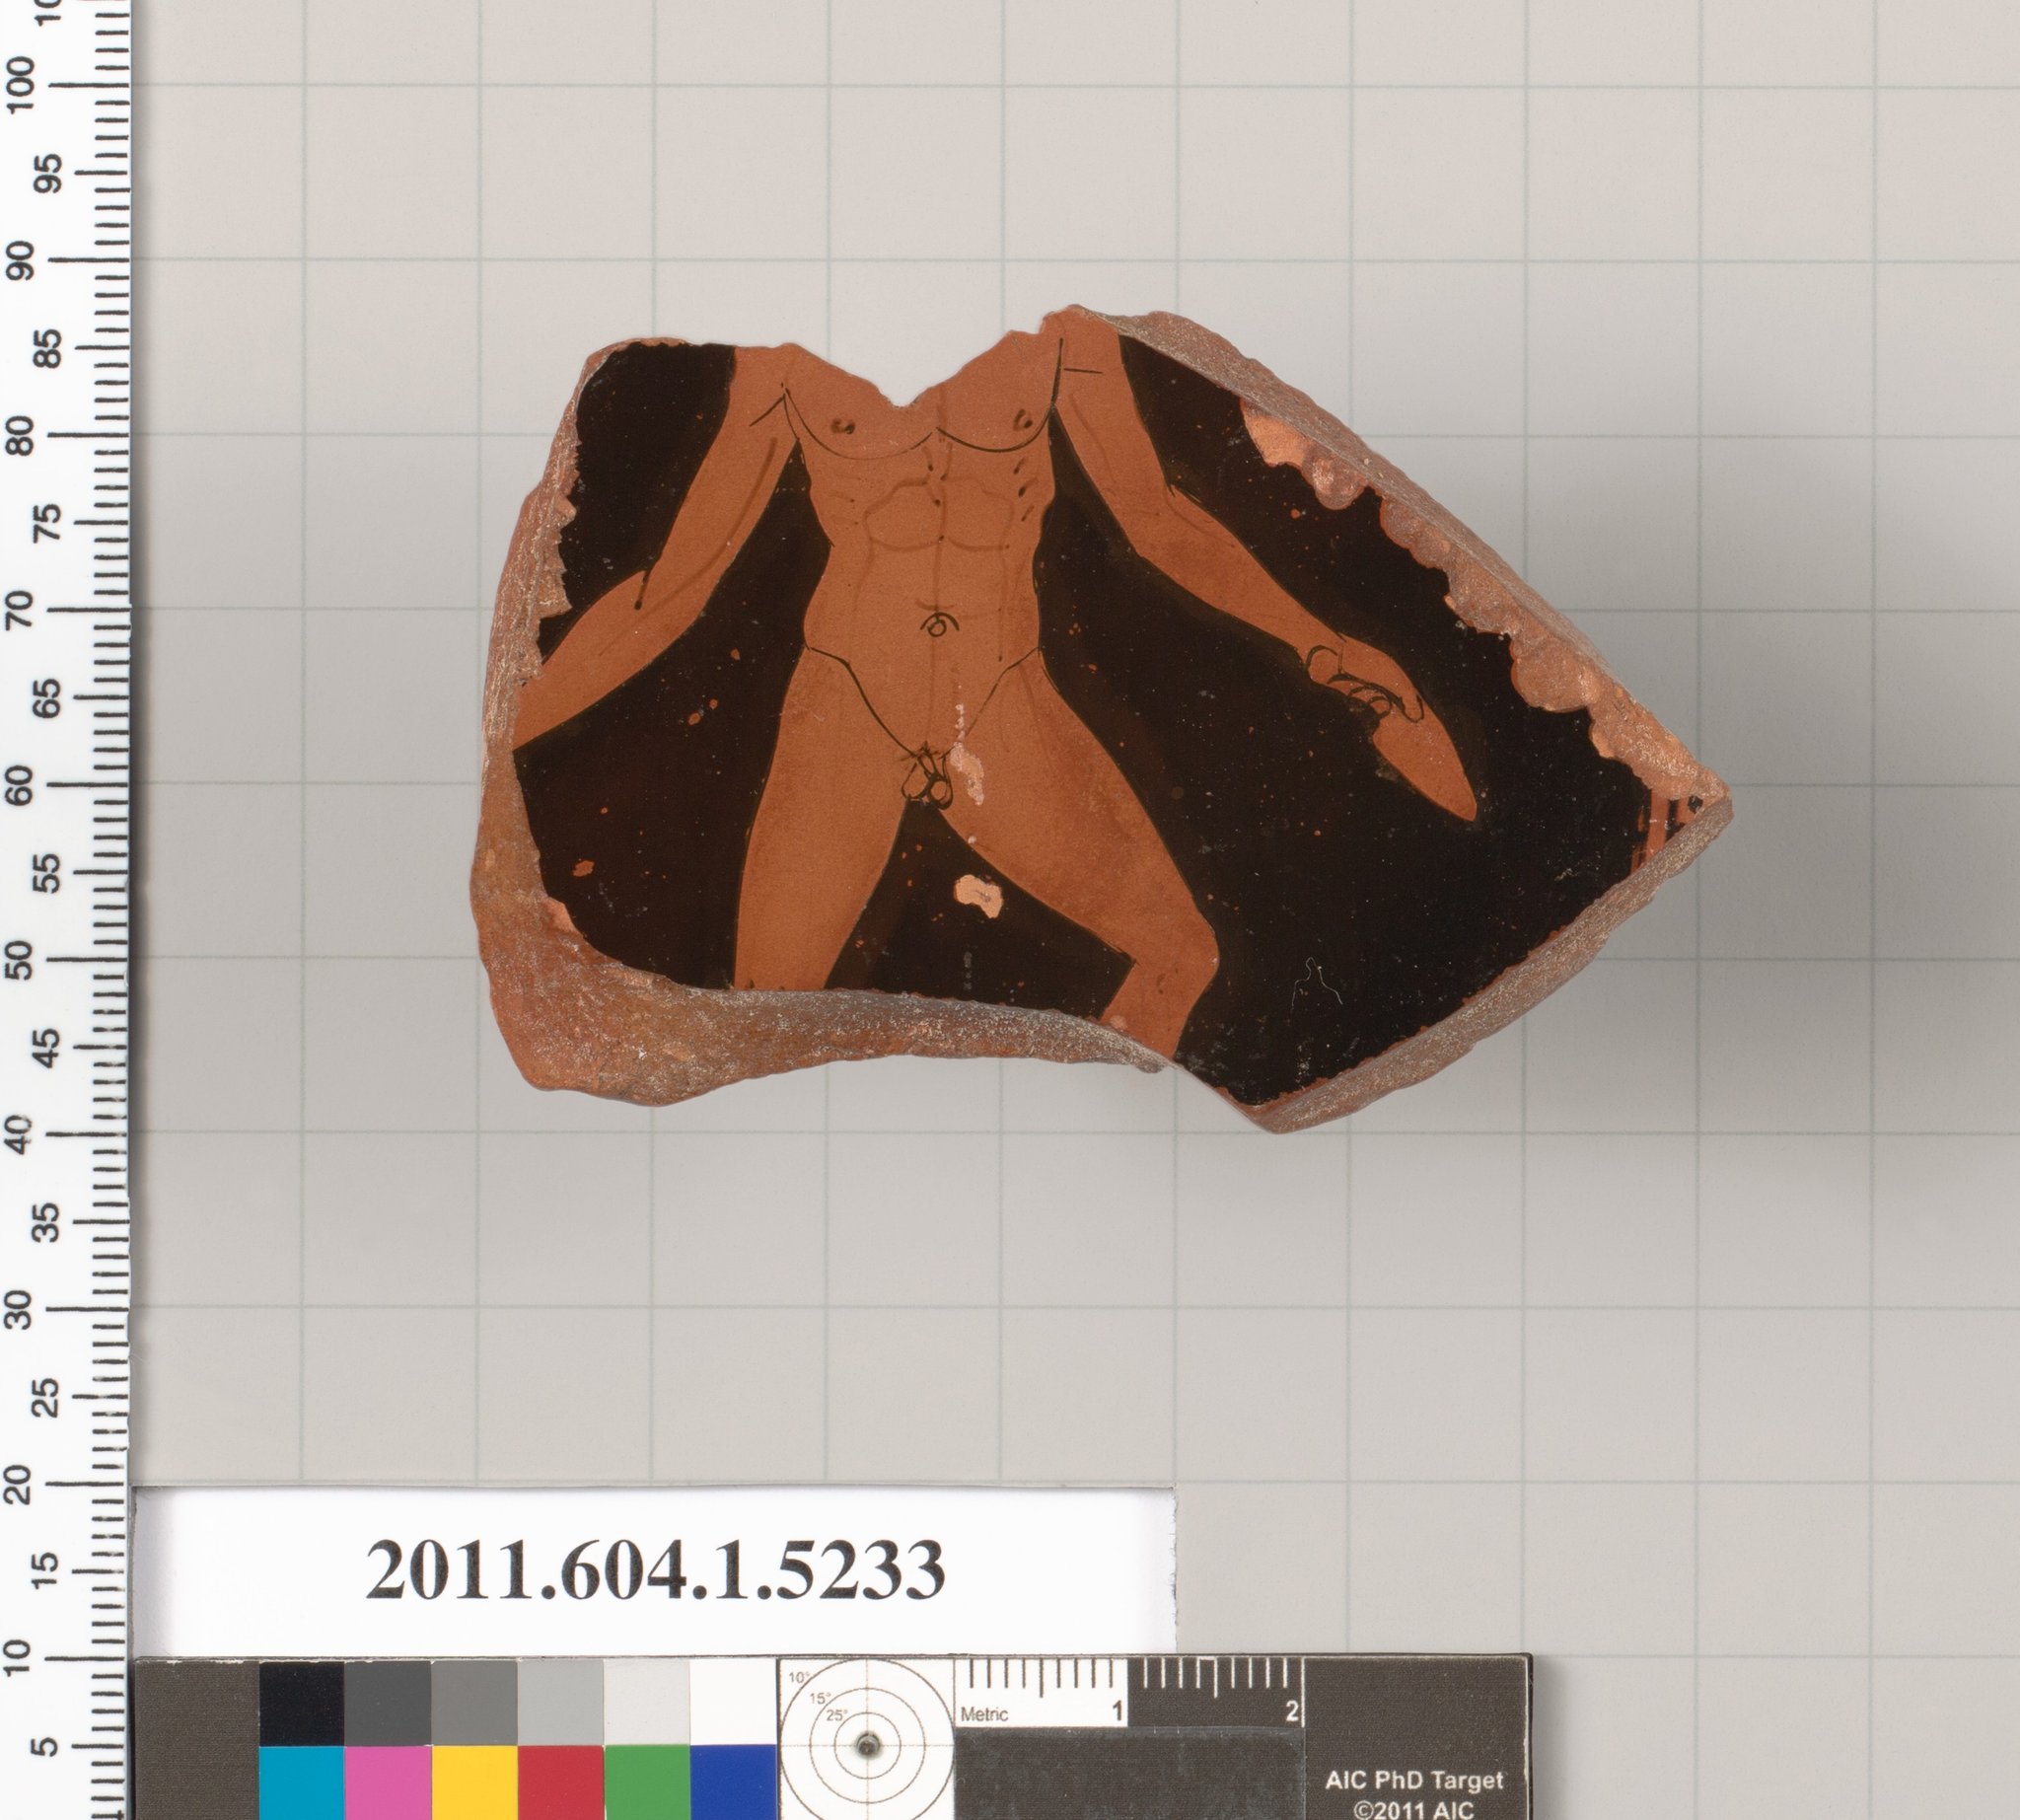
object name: kylix fragment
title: Terracotta fragment of a kylix (drinking cup)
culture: greek, attic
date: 475-451 BCE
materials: terracotta